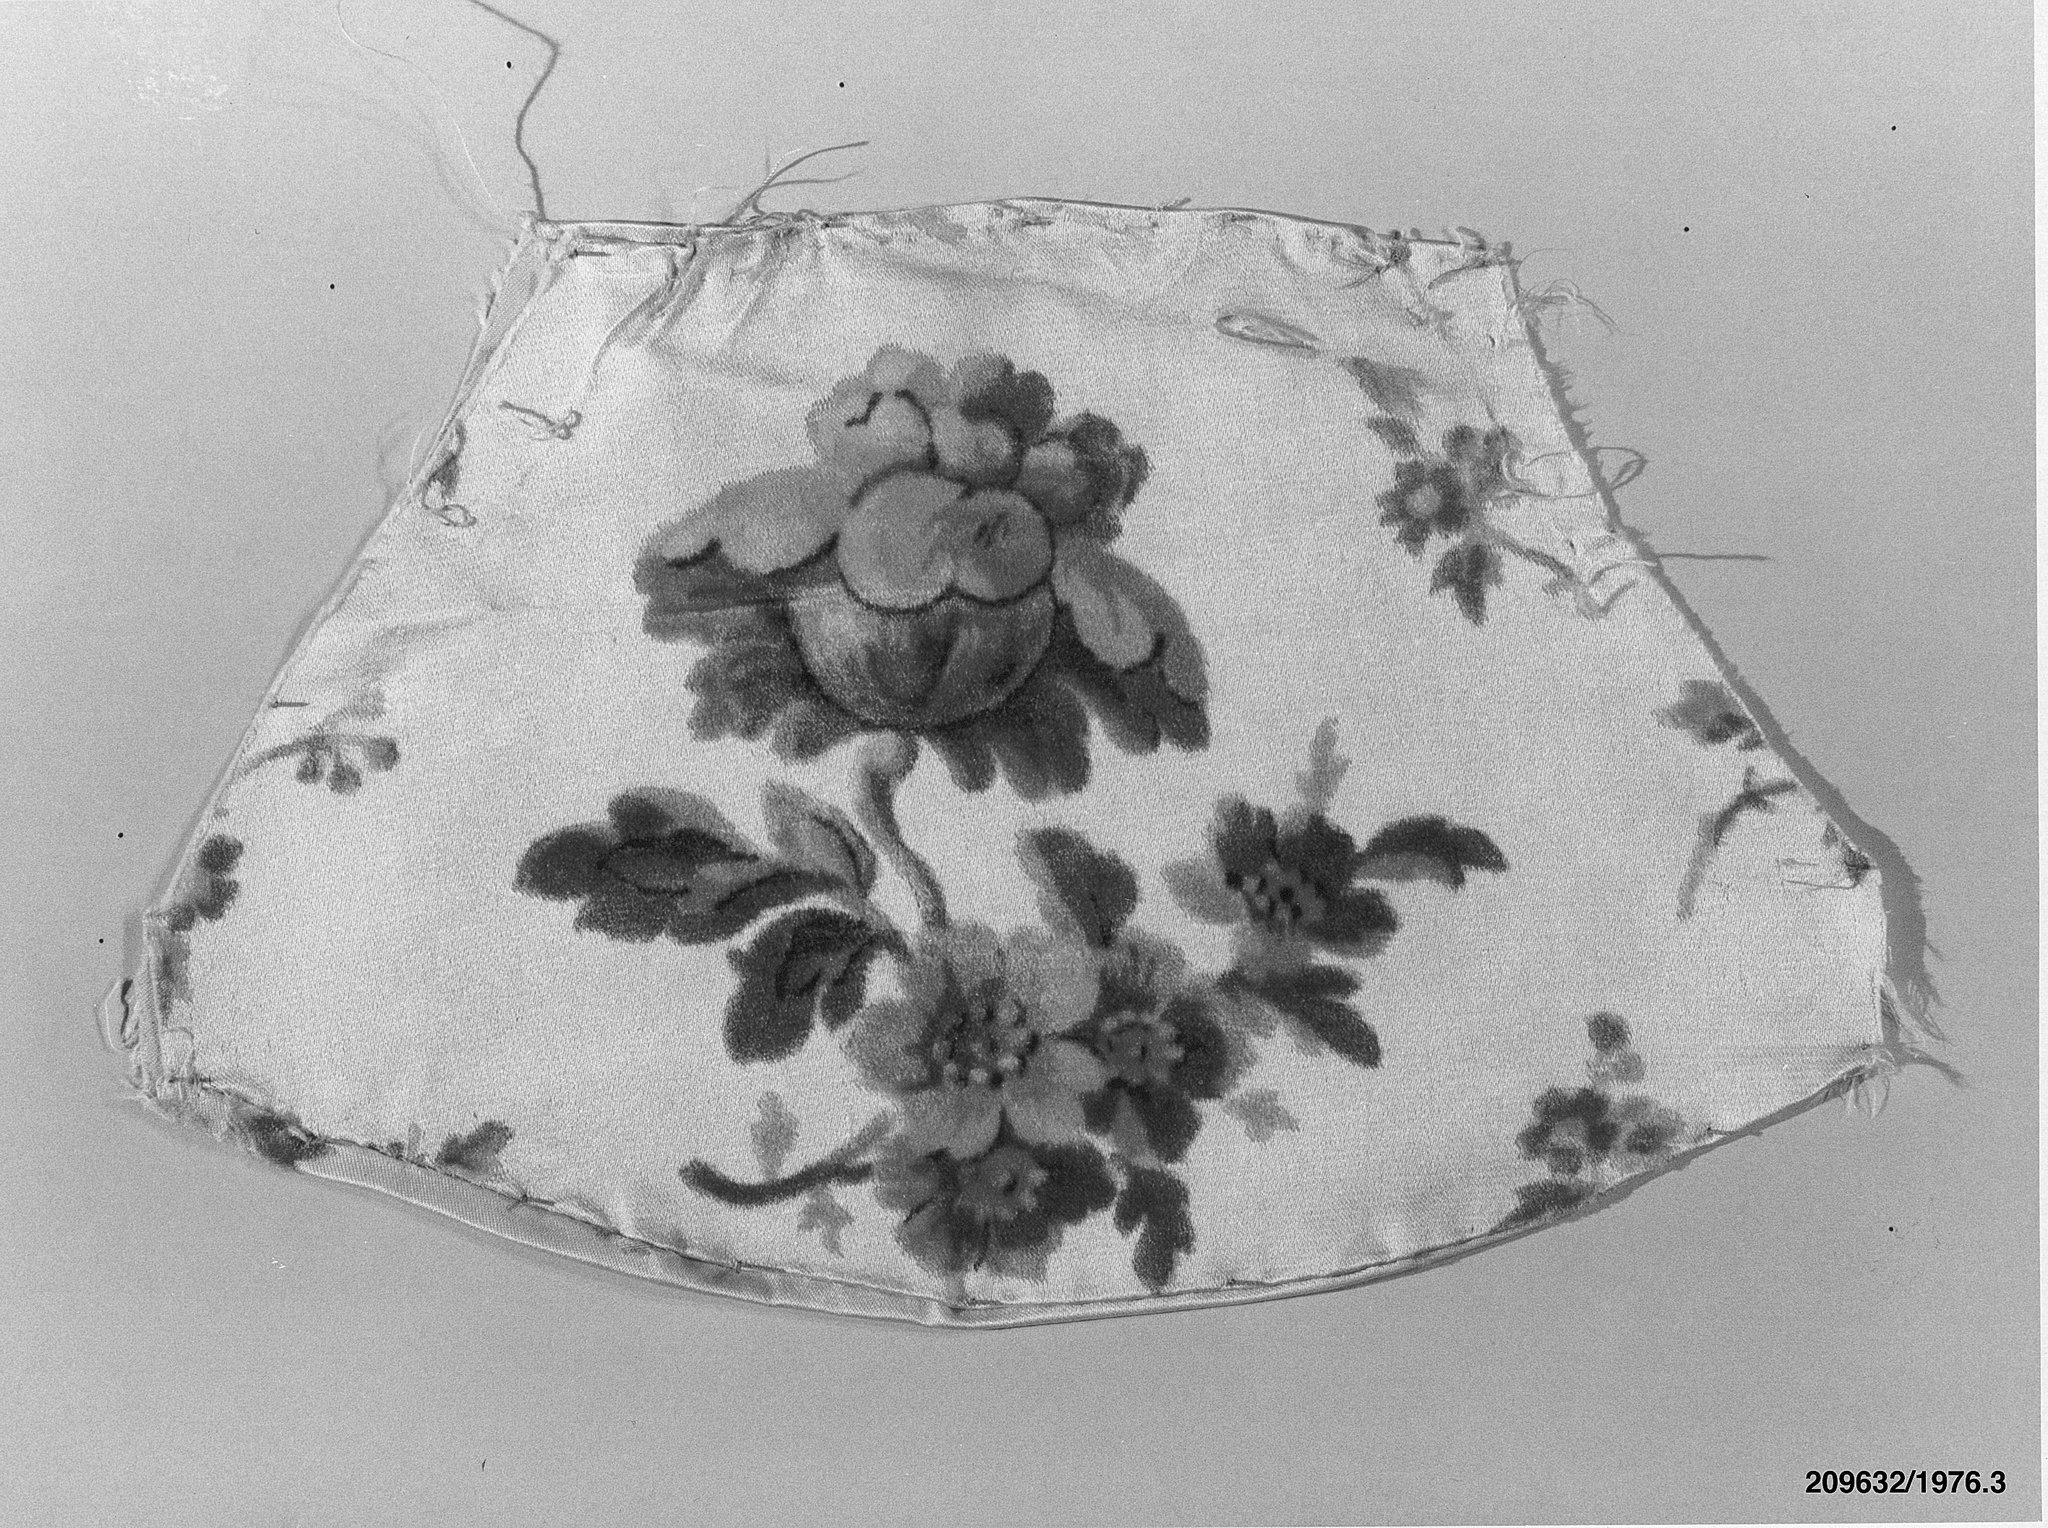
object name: piece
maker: charles frederick worth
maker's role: designer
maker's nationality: french, born england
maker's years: 1825-1895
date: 1880-1889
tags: flowers,leaves